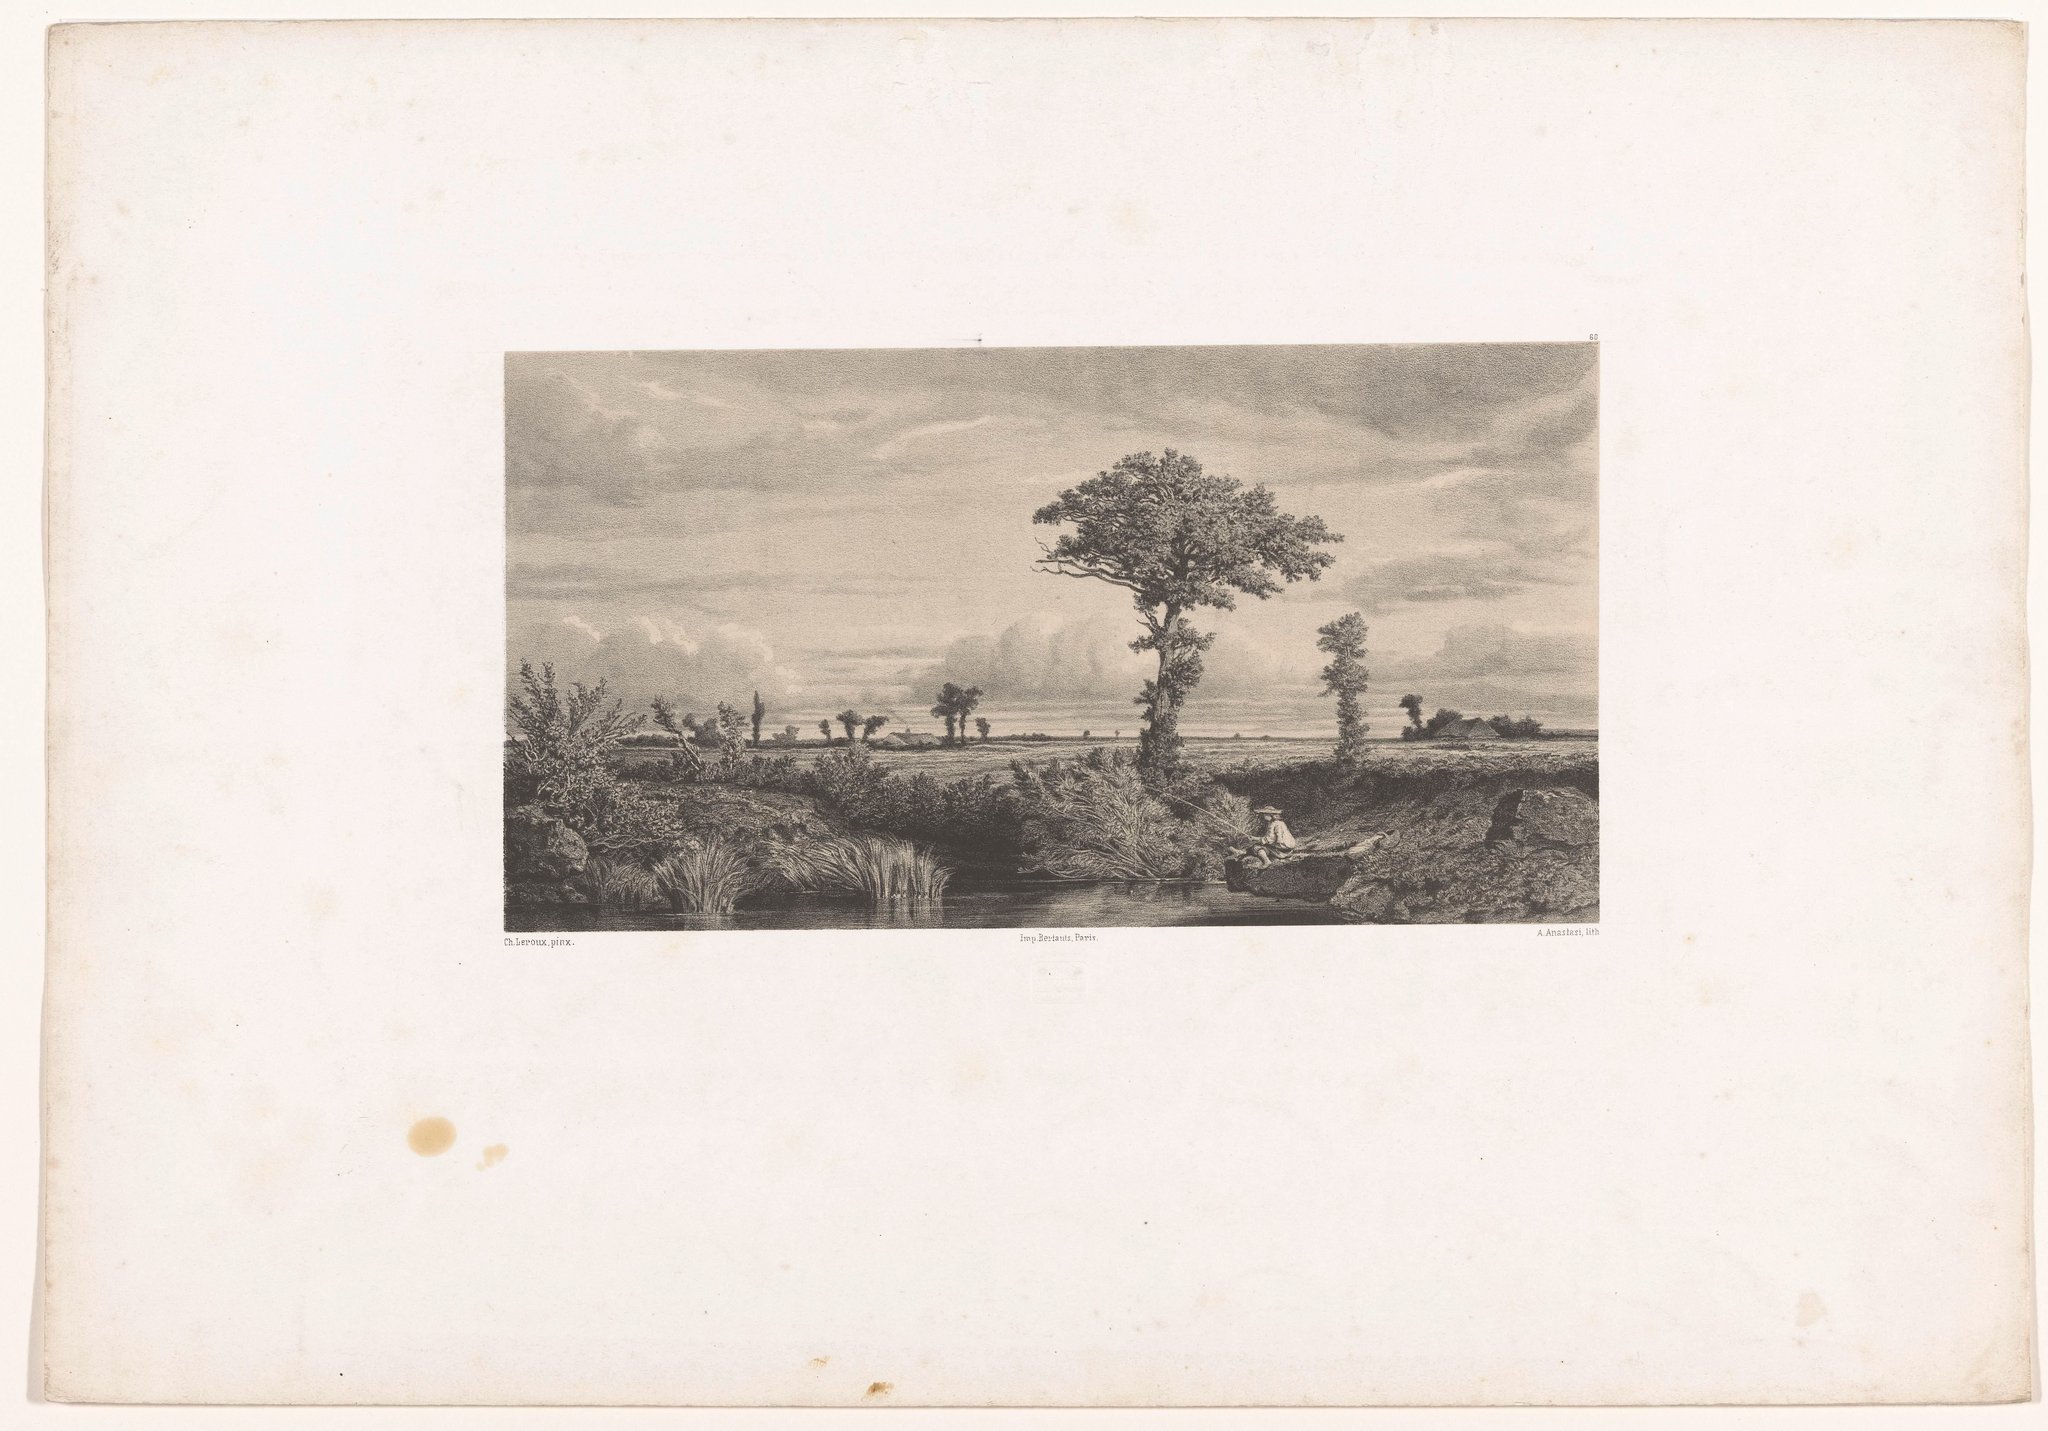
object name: print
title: Eigentijdse kunstenaars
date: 1848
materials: paper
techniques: tone lithography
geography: nantes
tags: meadow, pasture, trees: oak, brook, fishing (sports), fisherman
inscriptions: collector's mark: Lugt 2228, check stamp: Lugt 36b